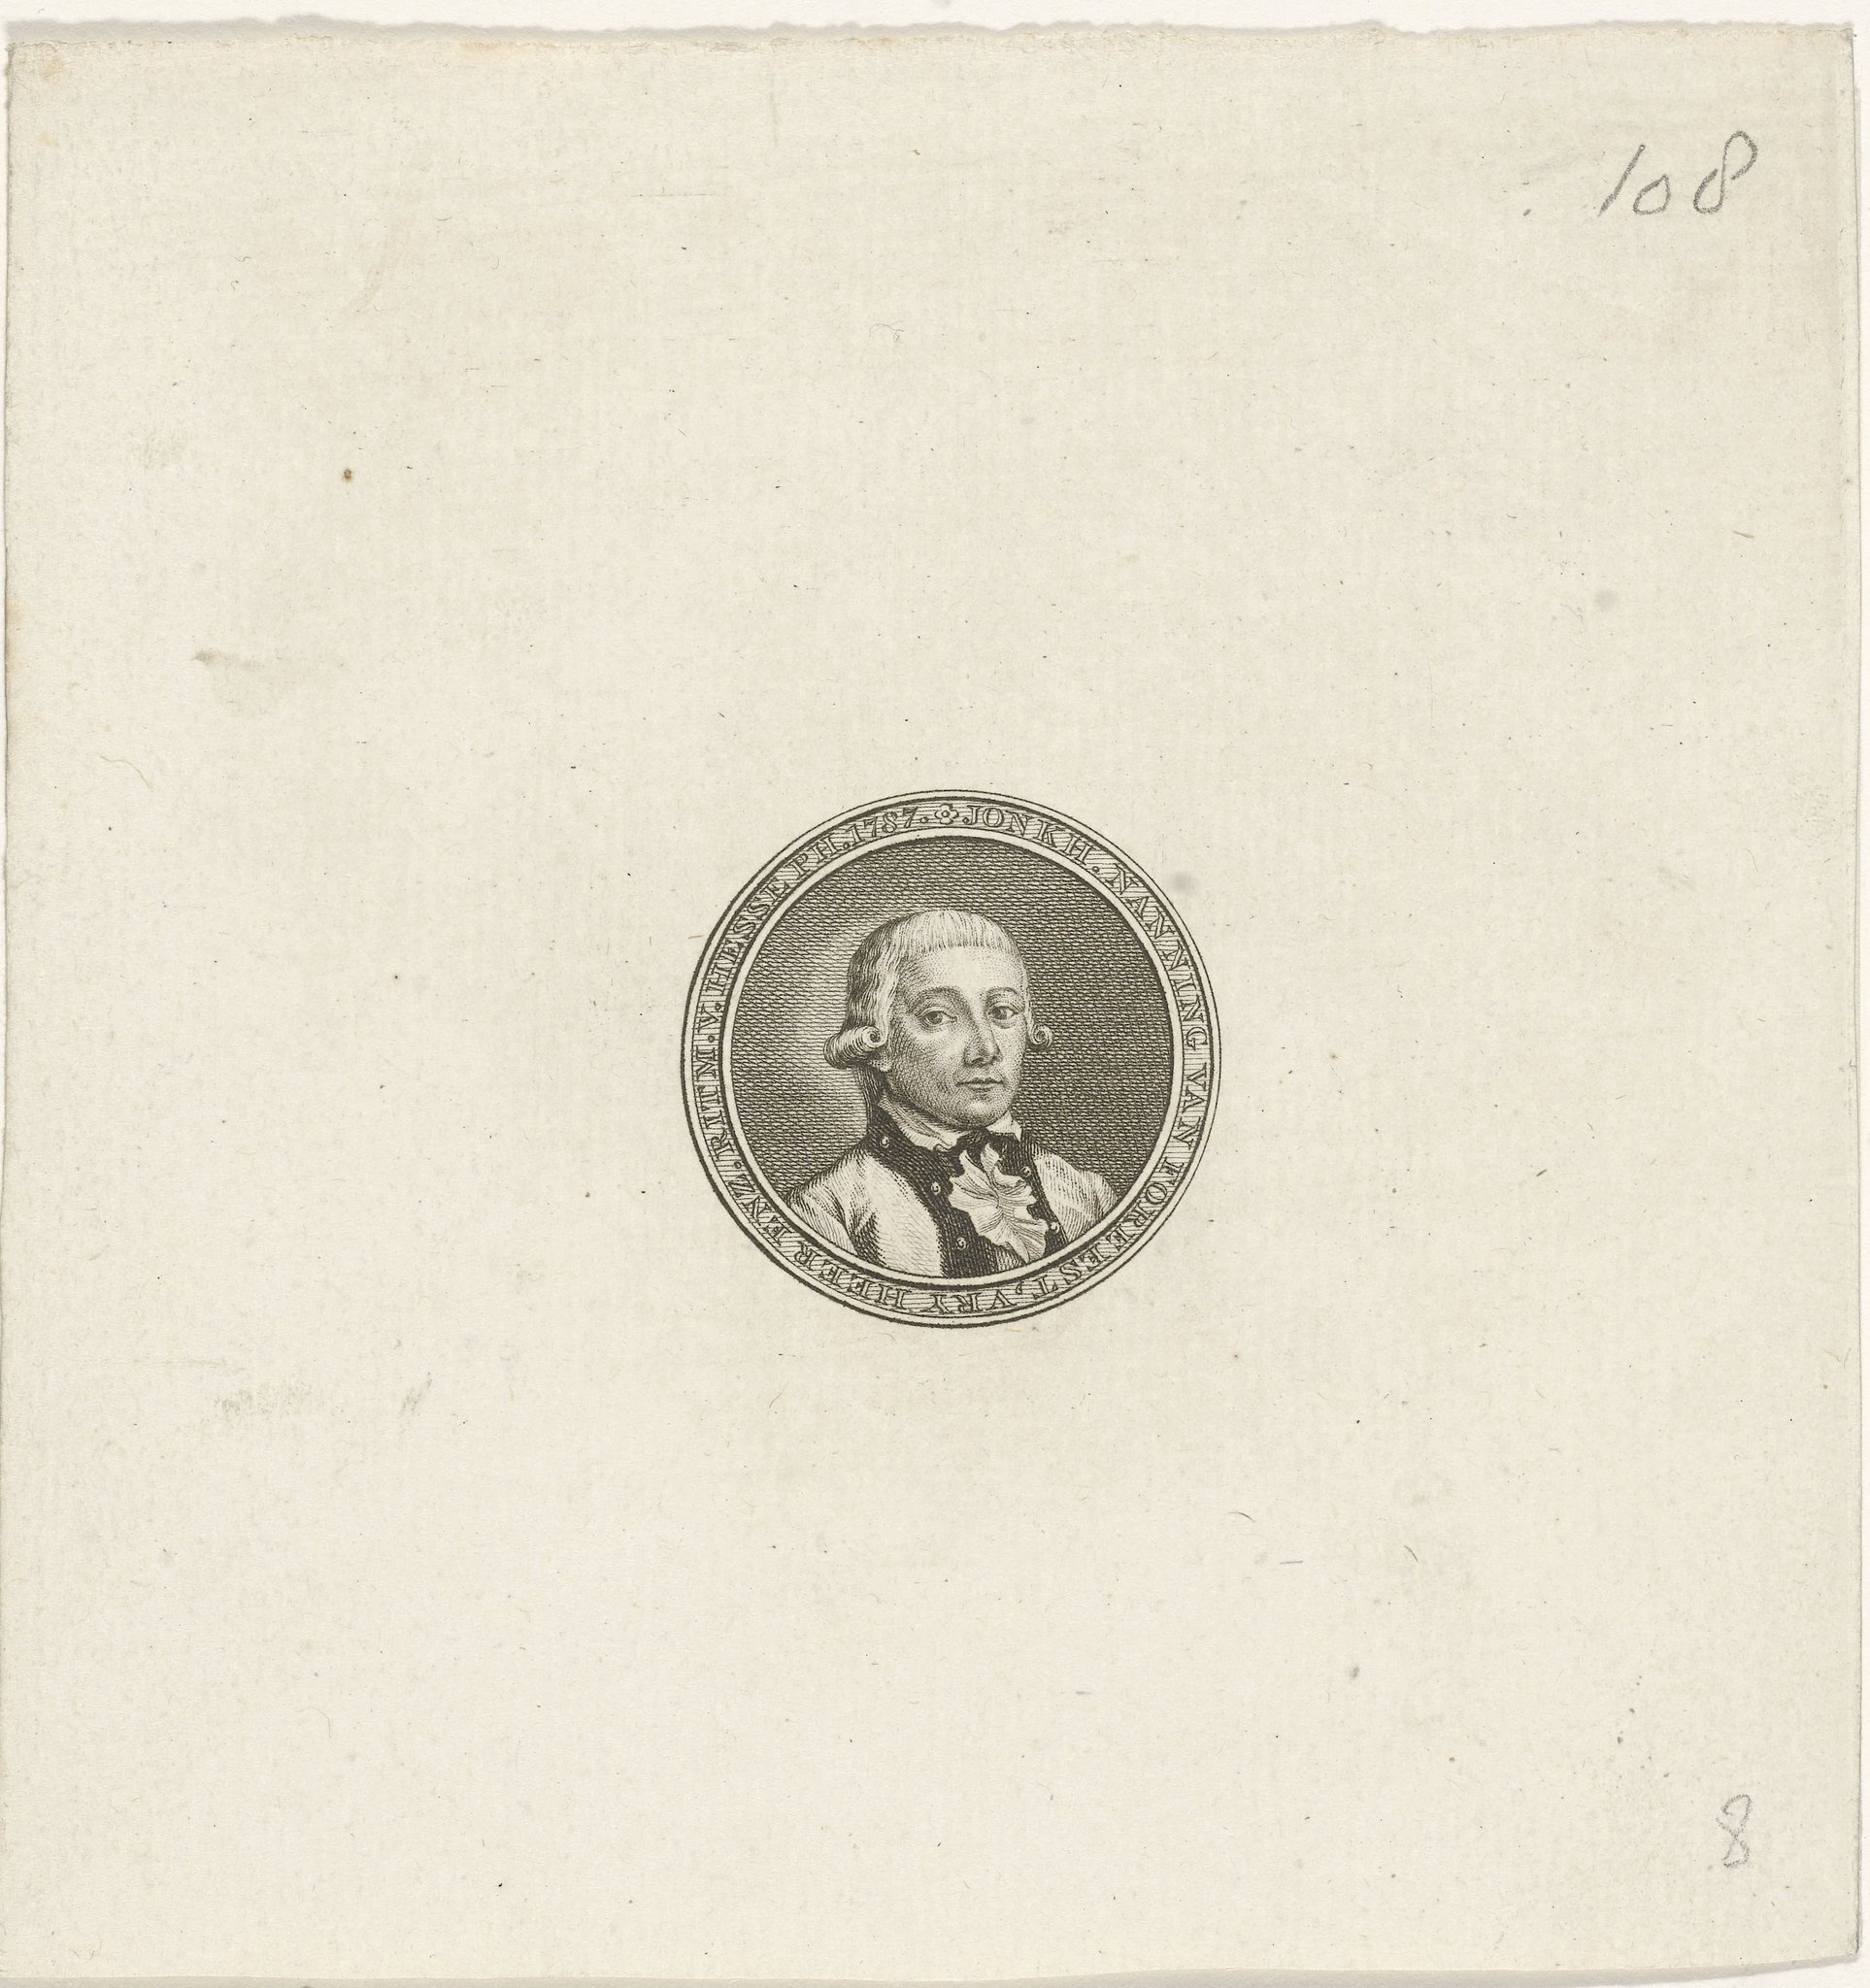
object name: print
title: Portretten van patriotten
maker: abraham jacobsz. hulk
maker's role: print maker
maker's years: 1751-1817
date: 1787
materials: paper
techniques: engraving, etching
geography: paris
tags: nanning van foreest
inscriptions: collector's mark: Lugt 2228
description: Buste van Nanning van Foreest naar rechts in een medaillon met randschrift in het Nederlands.